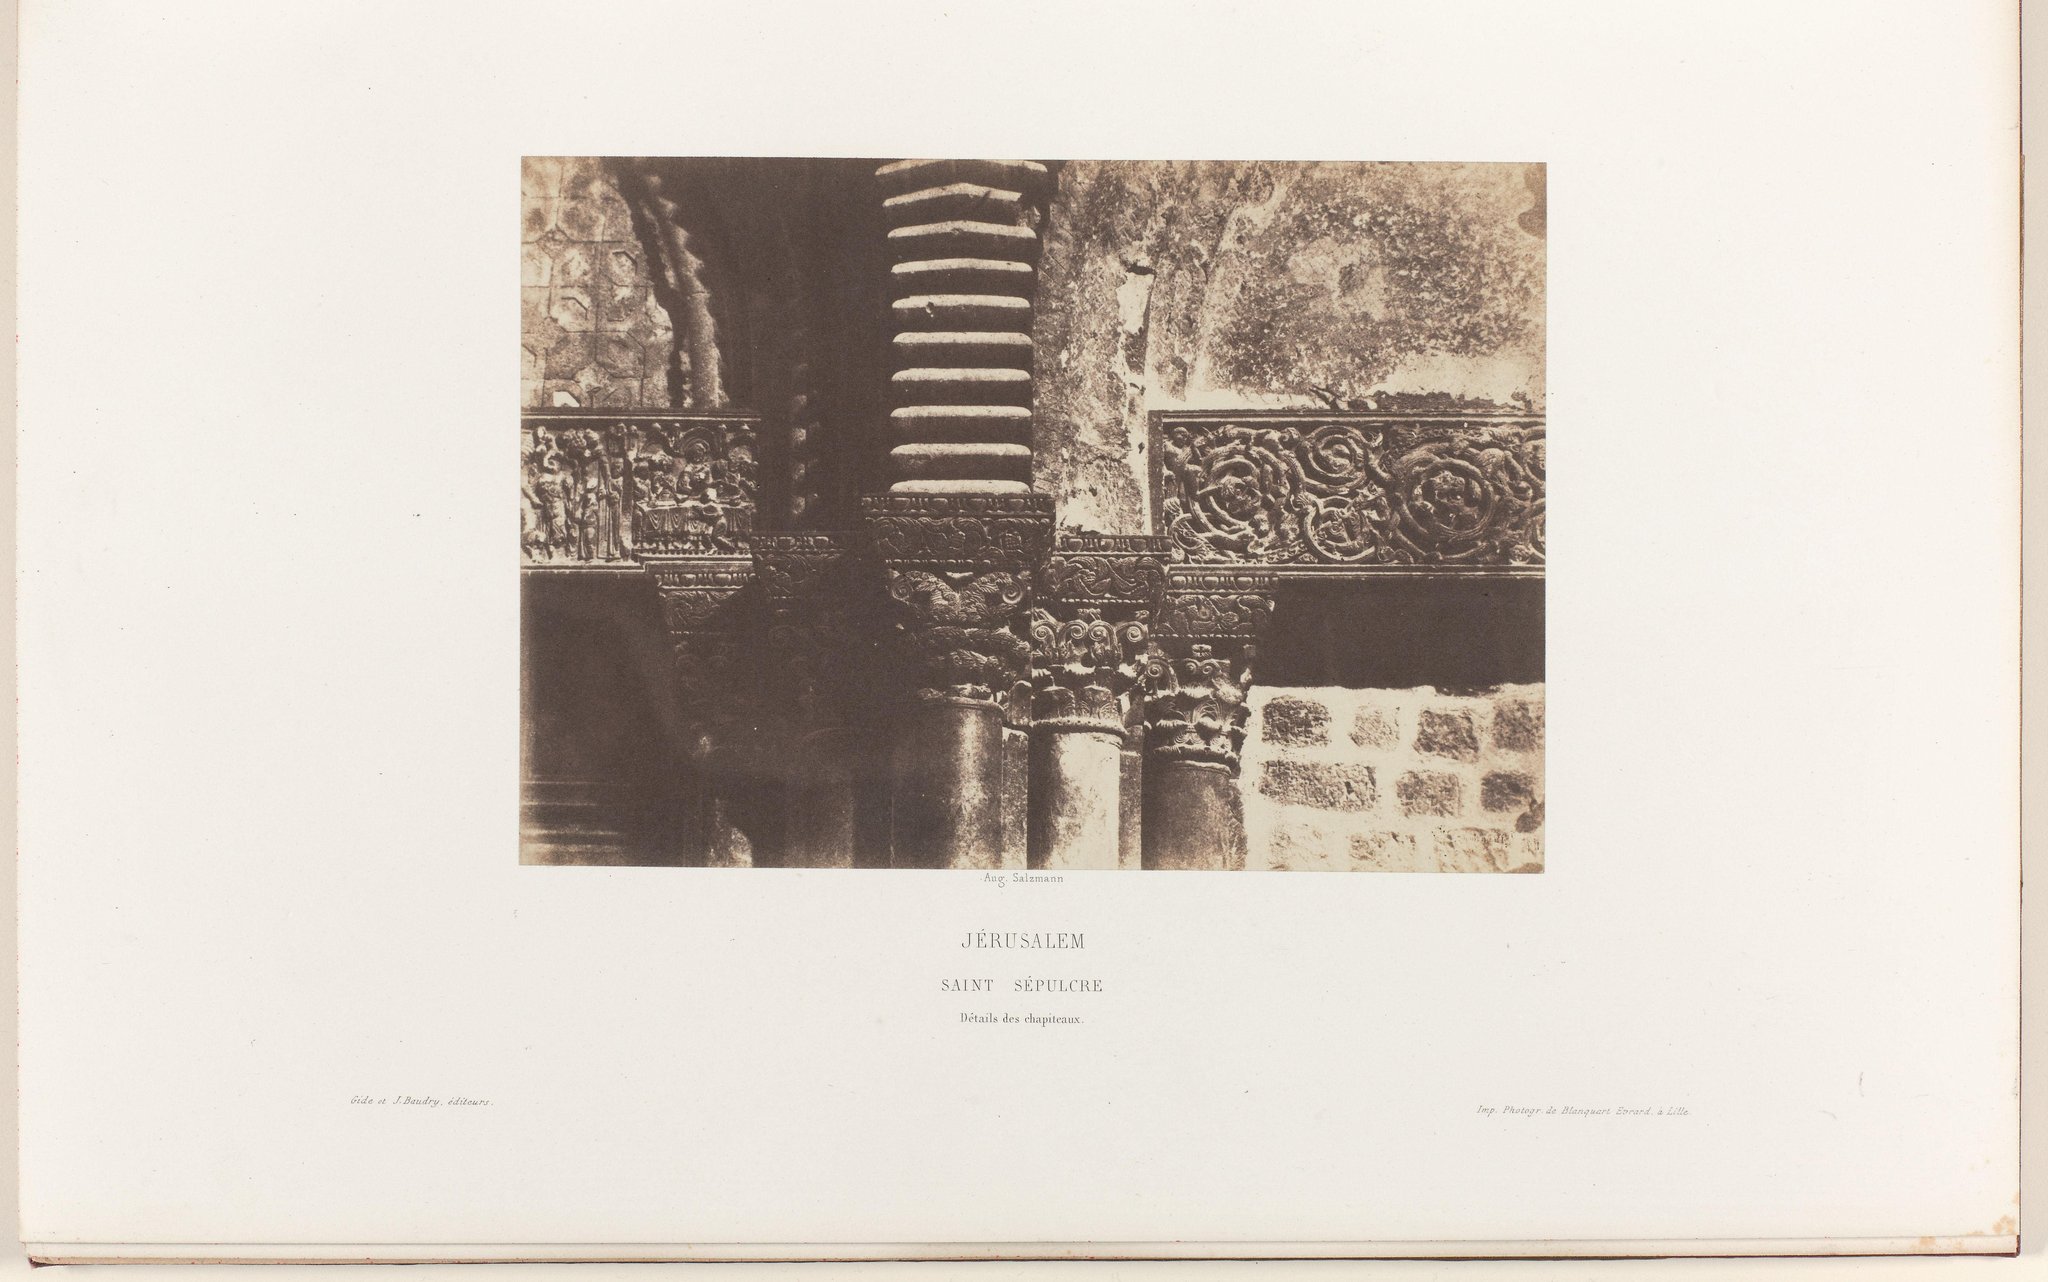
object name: photograph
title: Kapitelen van de Heilig Grafkerk, Jeruzalem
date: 1854-1856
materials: cardboard, paper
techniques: salted paper print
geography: lille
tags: architectural detail, capital (~ column, pillar)